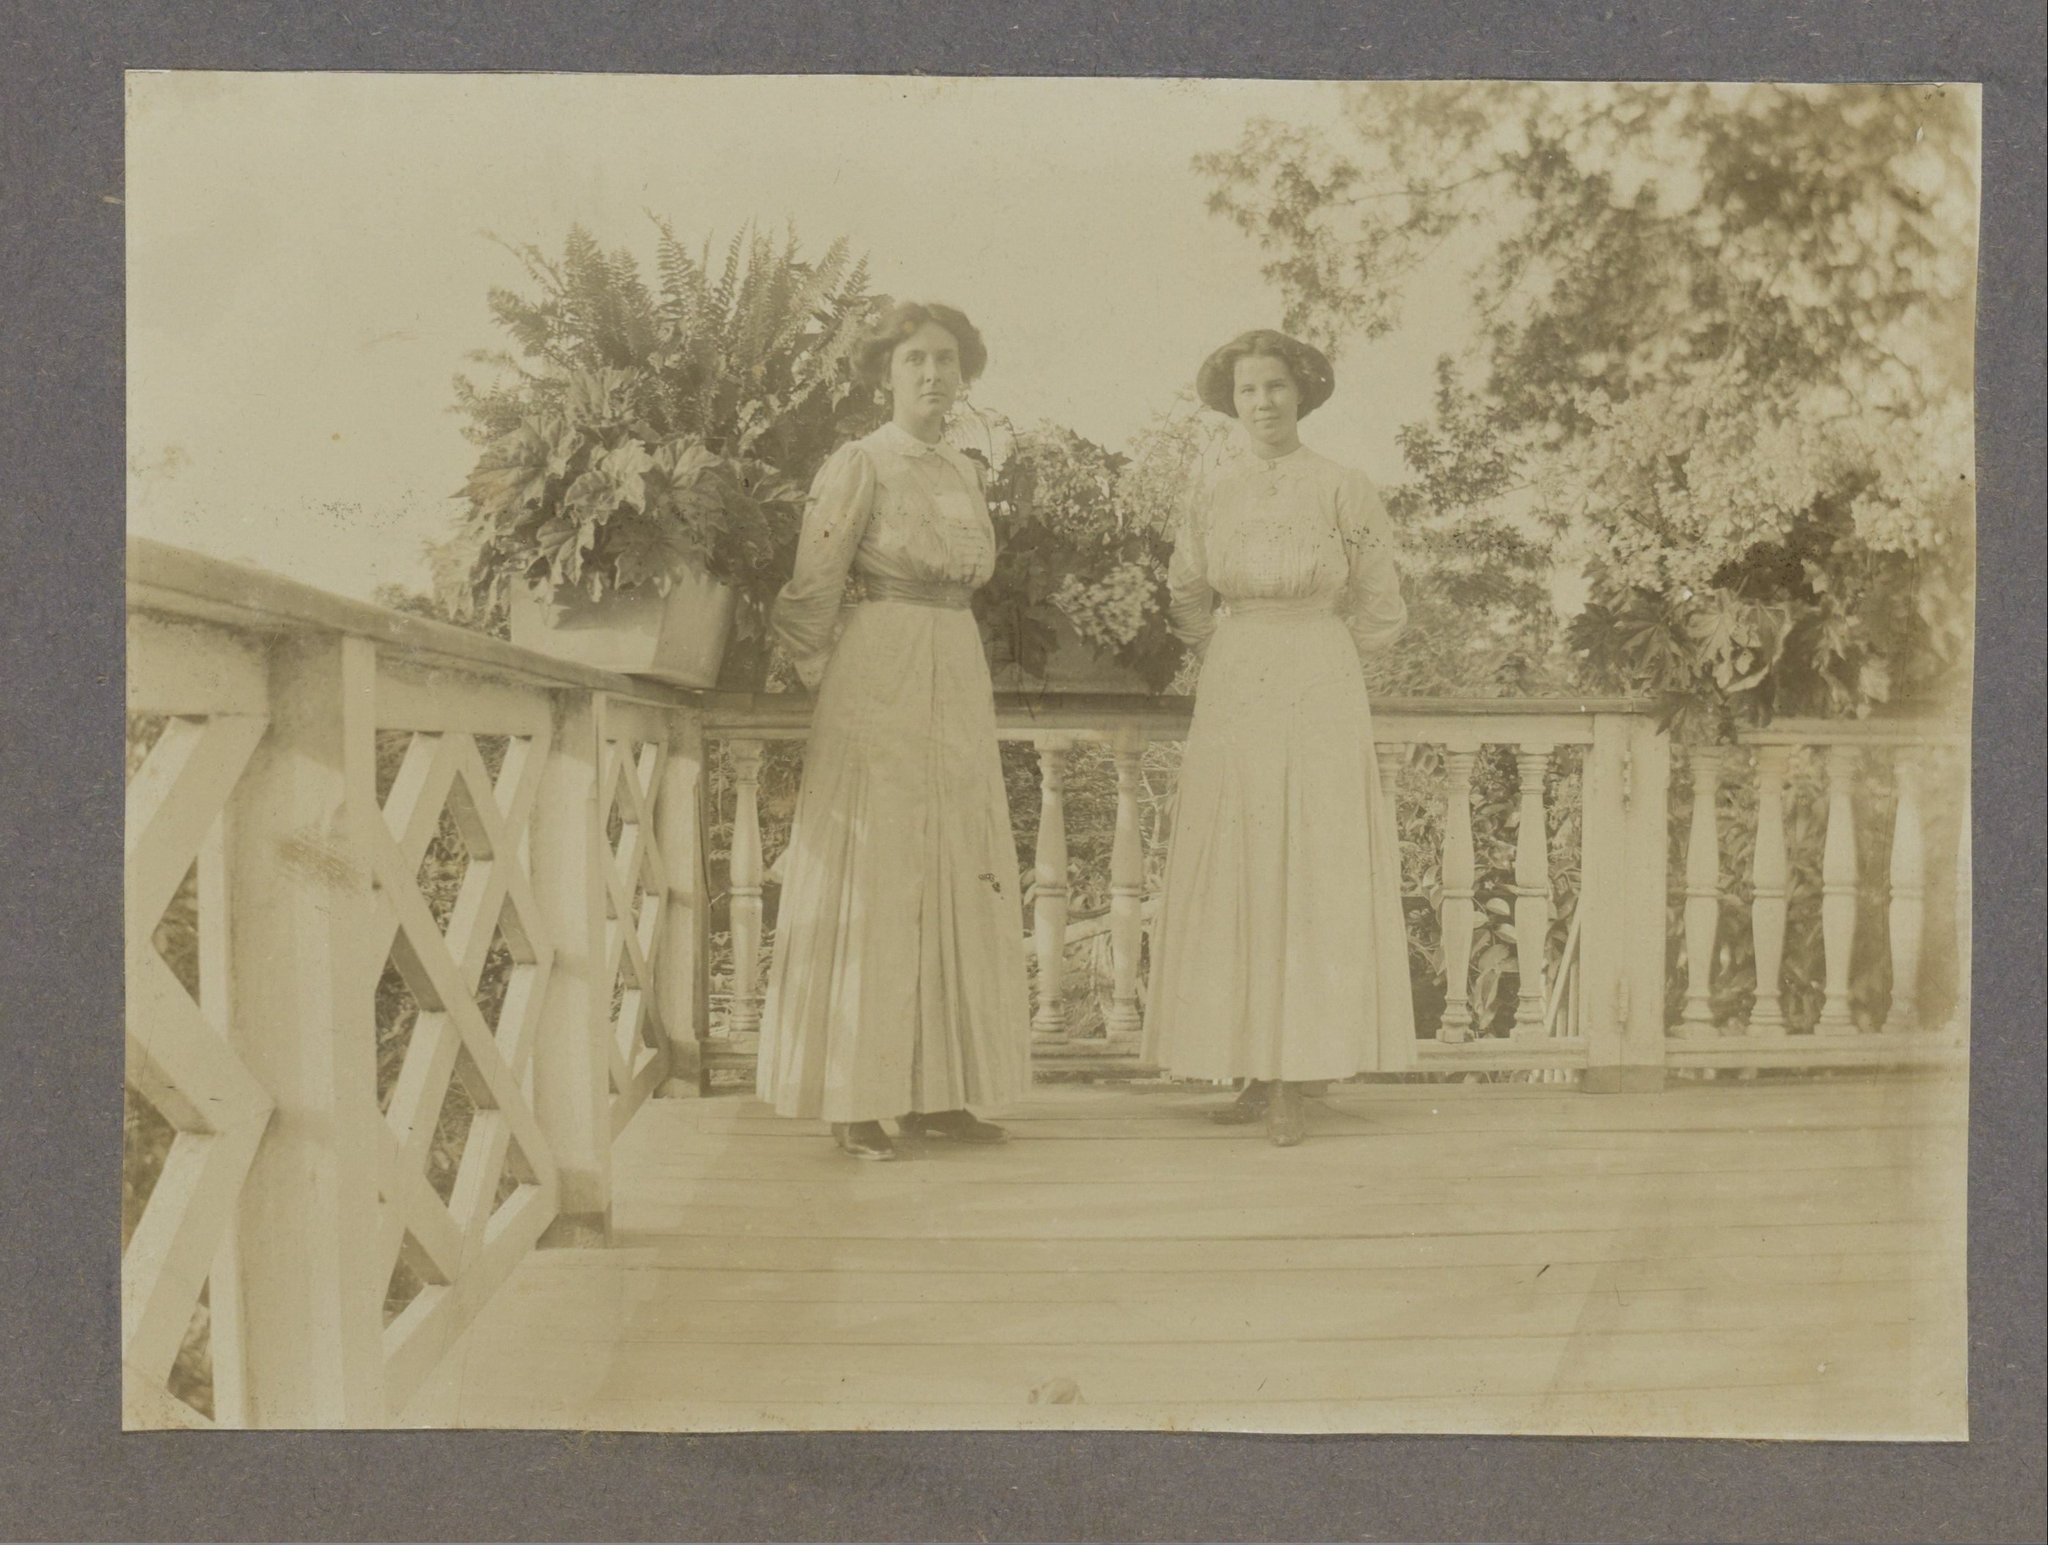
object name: photograph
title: Maria Gonggrijp en Sacha Croese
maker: Anonymous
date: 1912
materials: photographic support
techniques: photography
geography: suriname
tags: suriname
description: Maria Gonggrijp en Sacha Croese op de veranda. Onderdeel van het fotoalbum over het leven van de familie Gonggrijp in Suriname rond 1912.